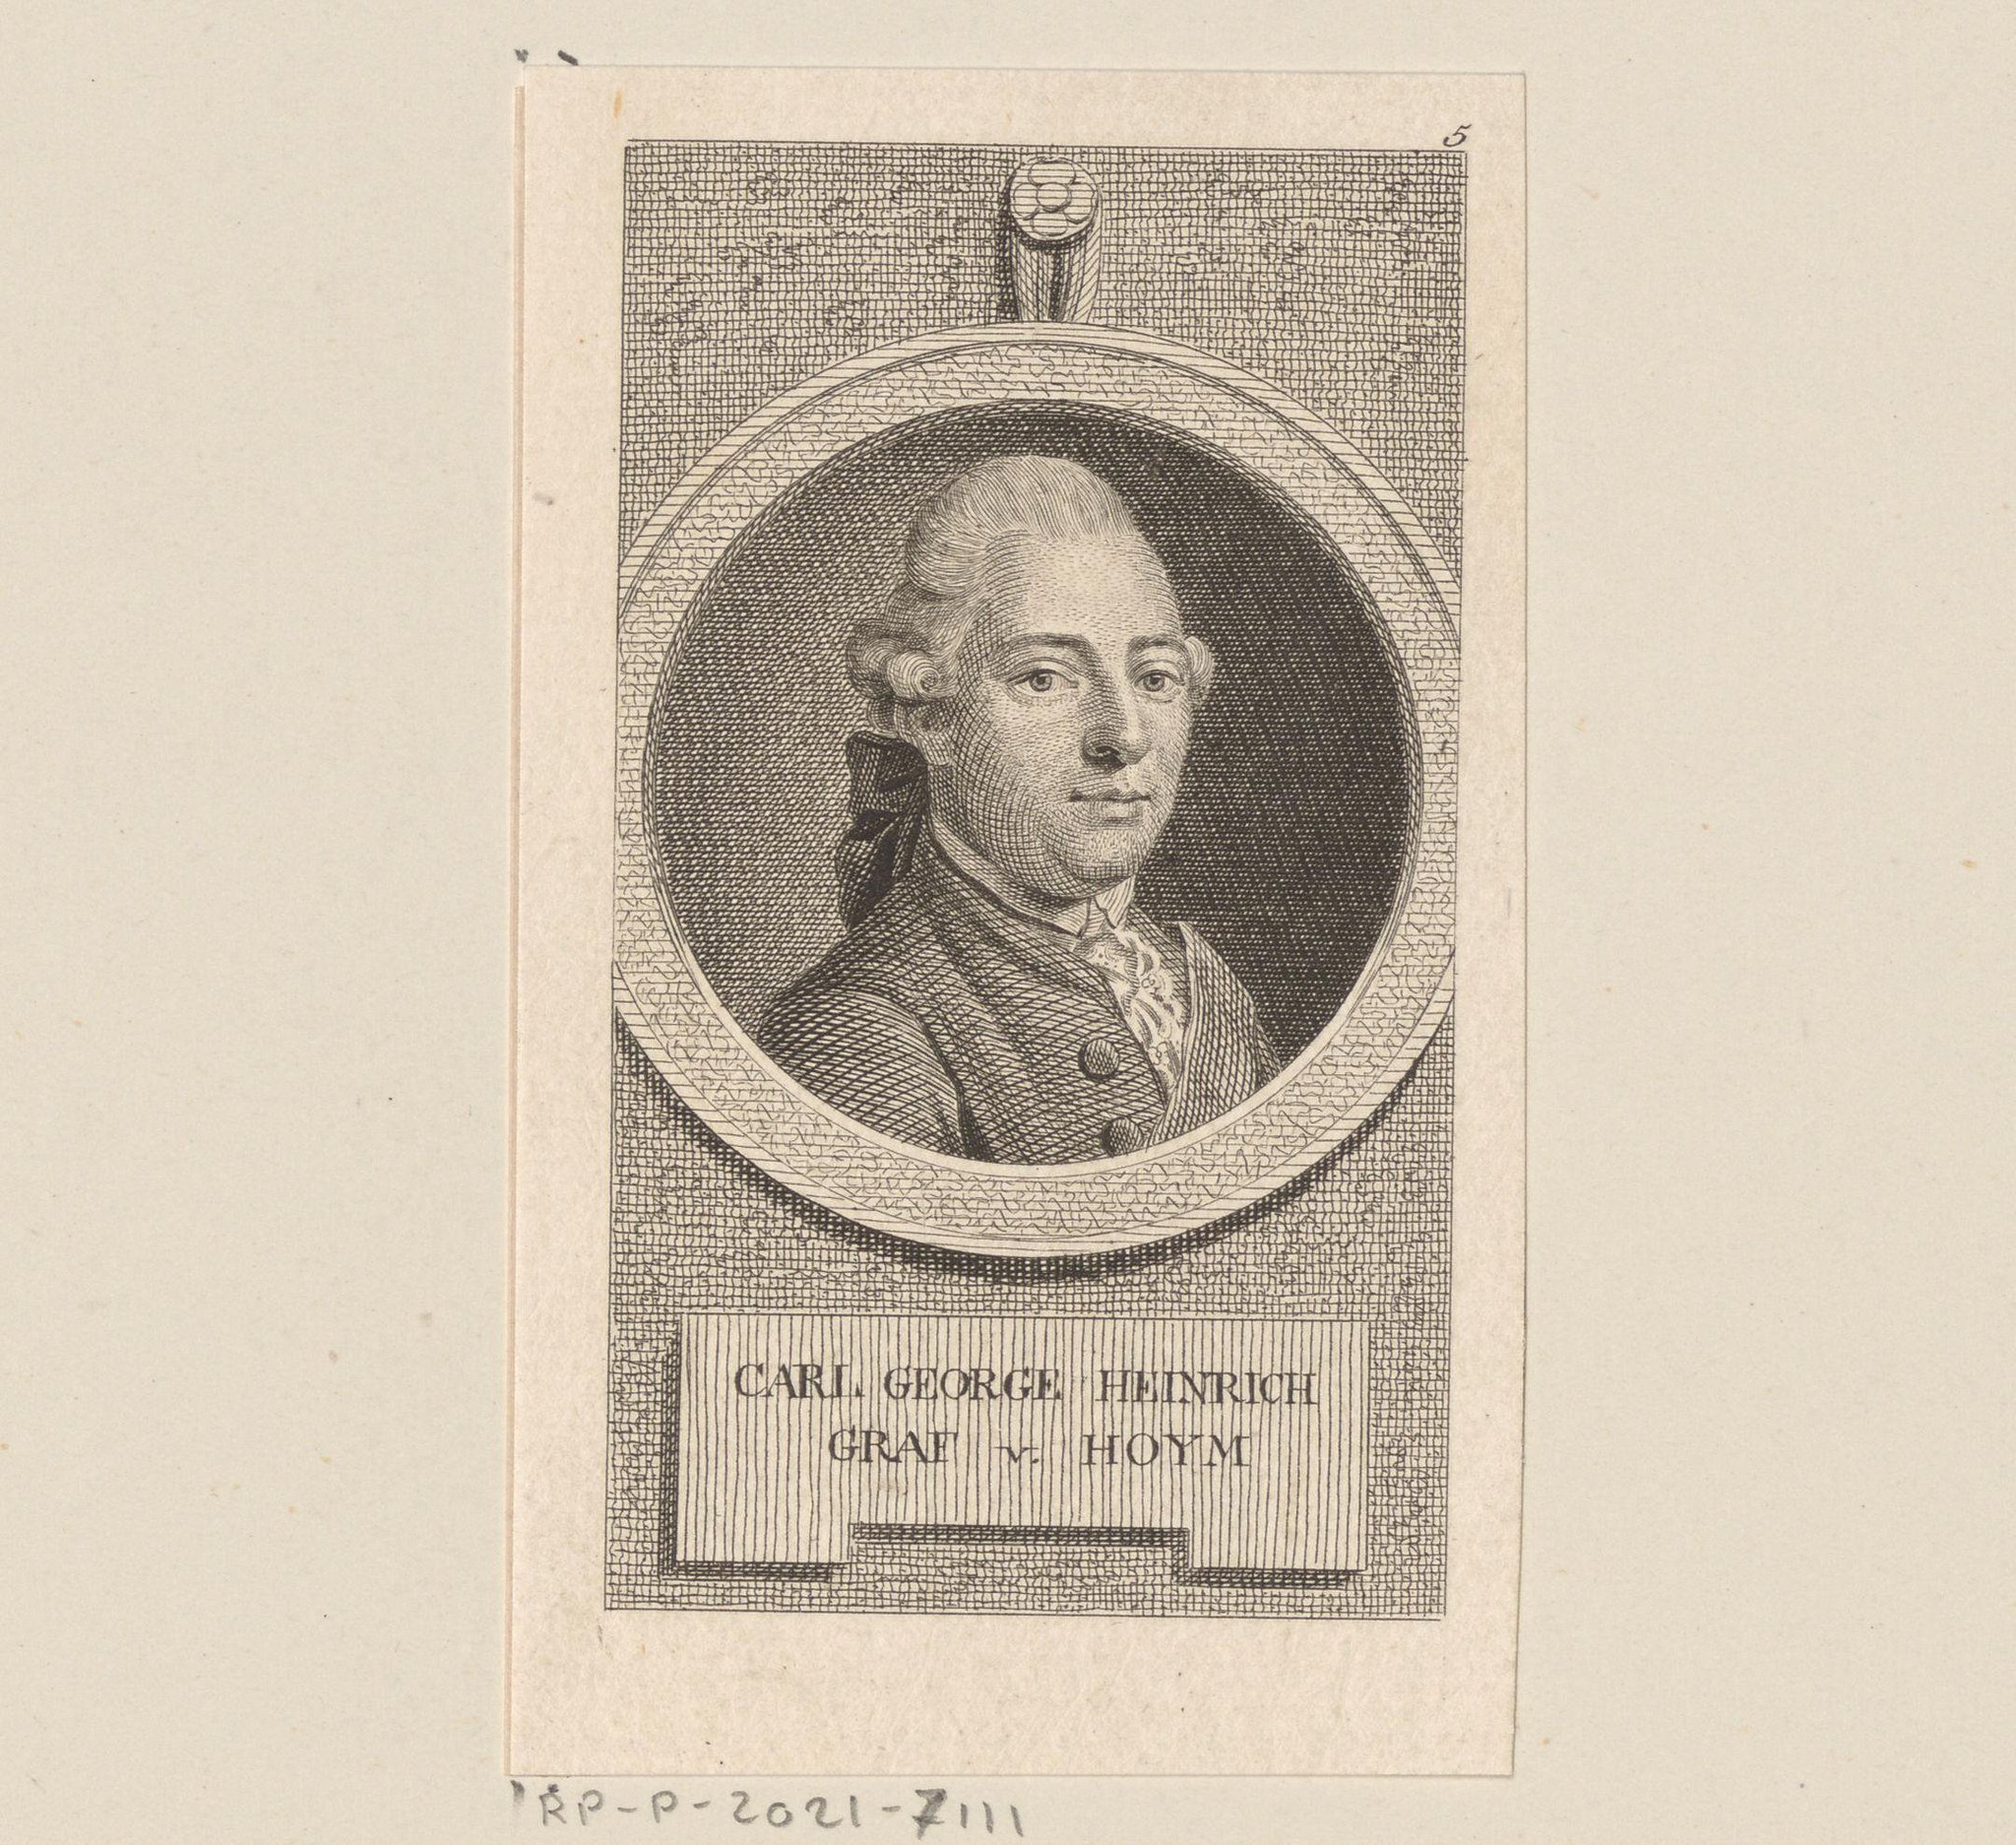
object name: print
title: Portret van Carl Georg Heinrich von Hoym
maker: Anonymous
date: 1800-1849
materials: paper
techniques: engraving, etching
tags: historical persons